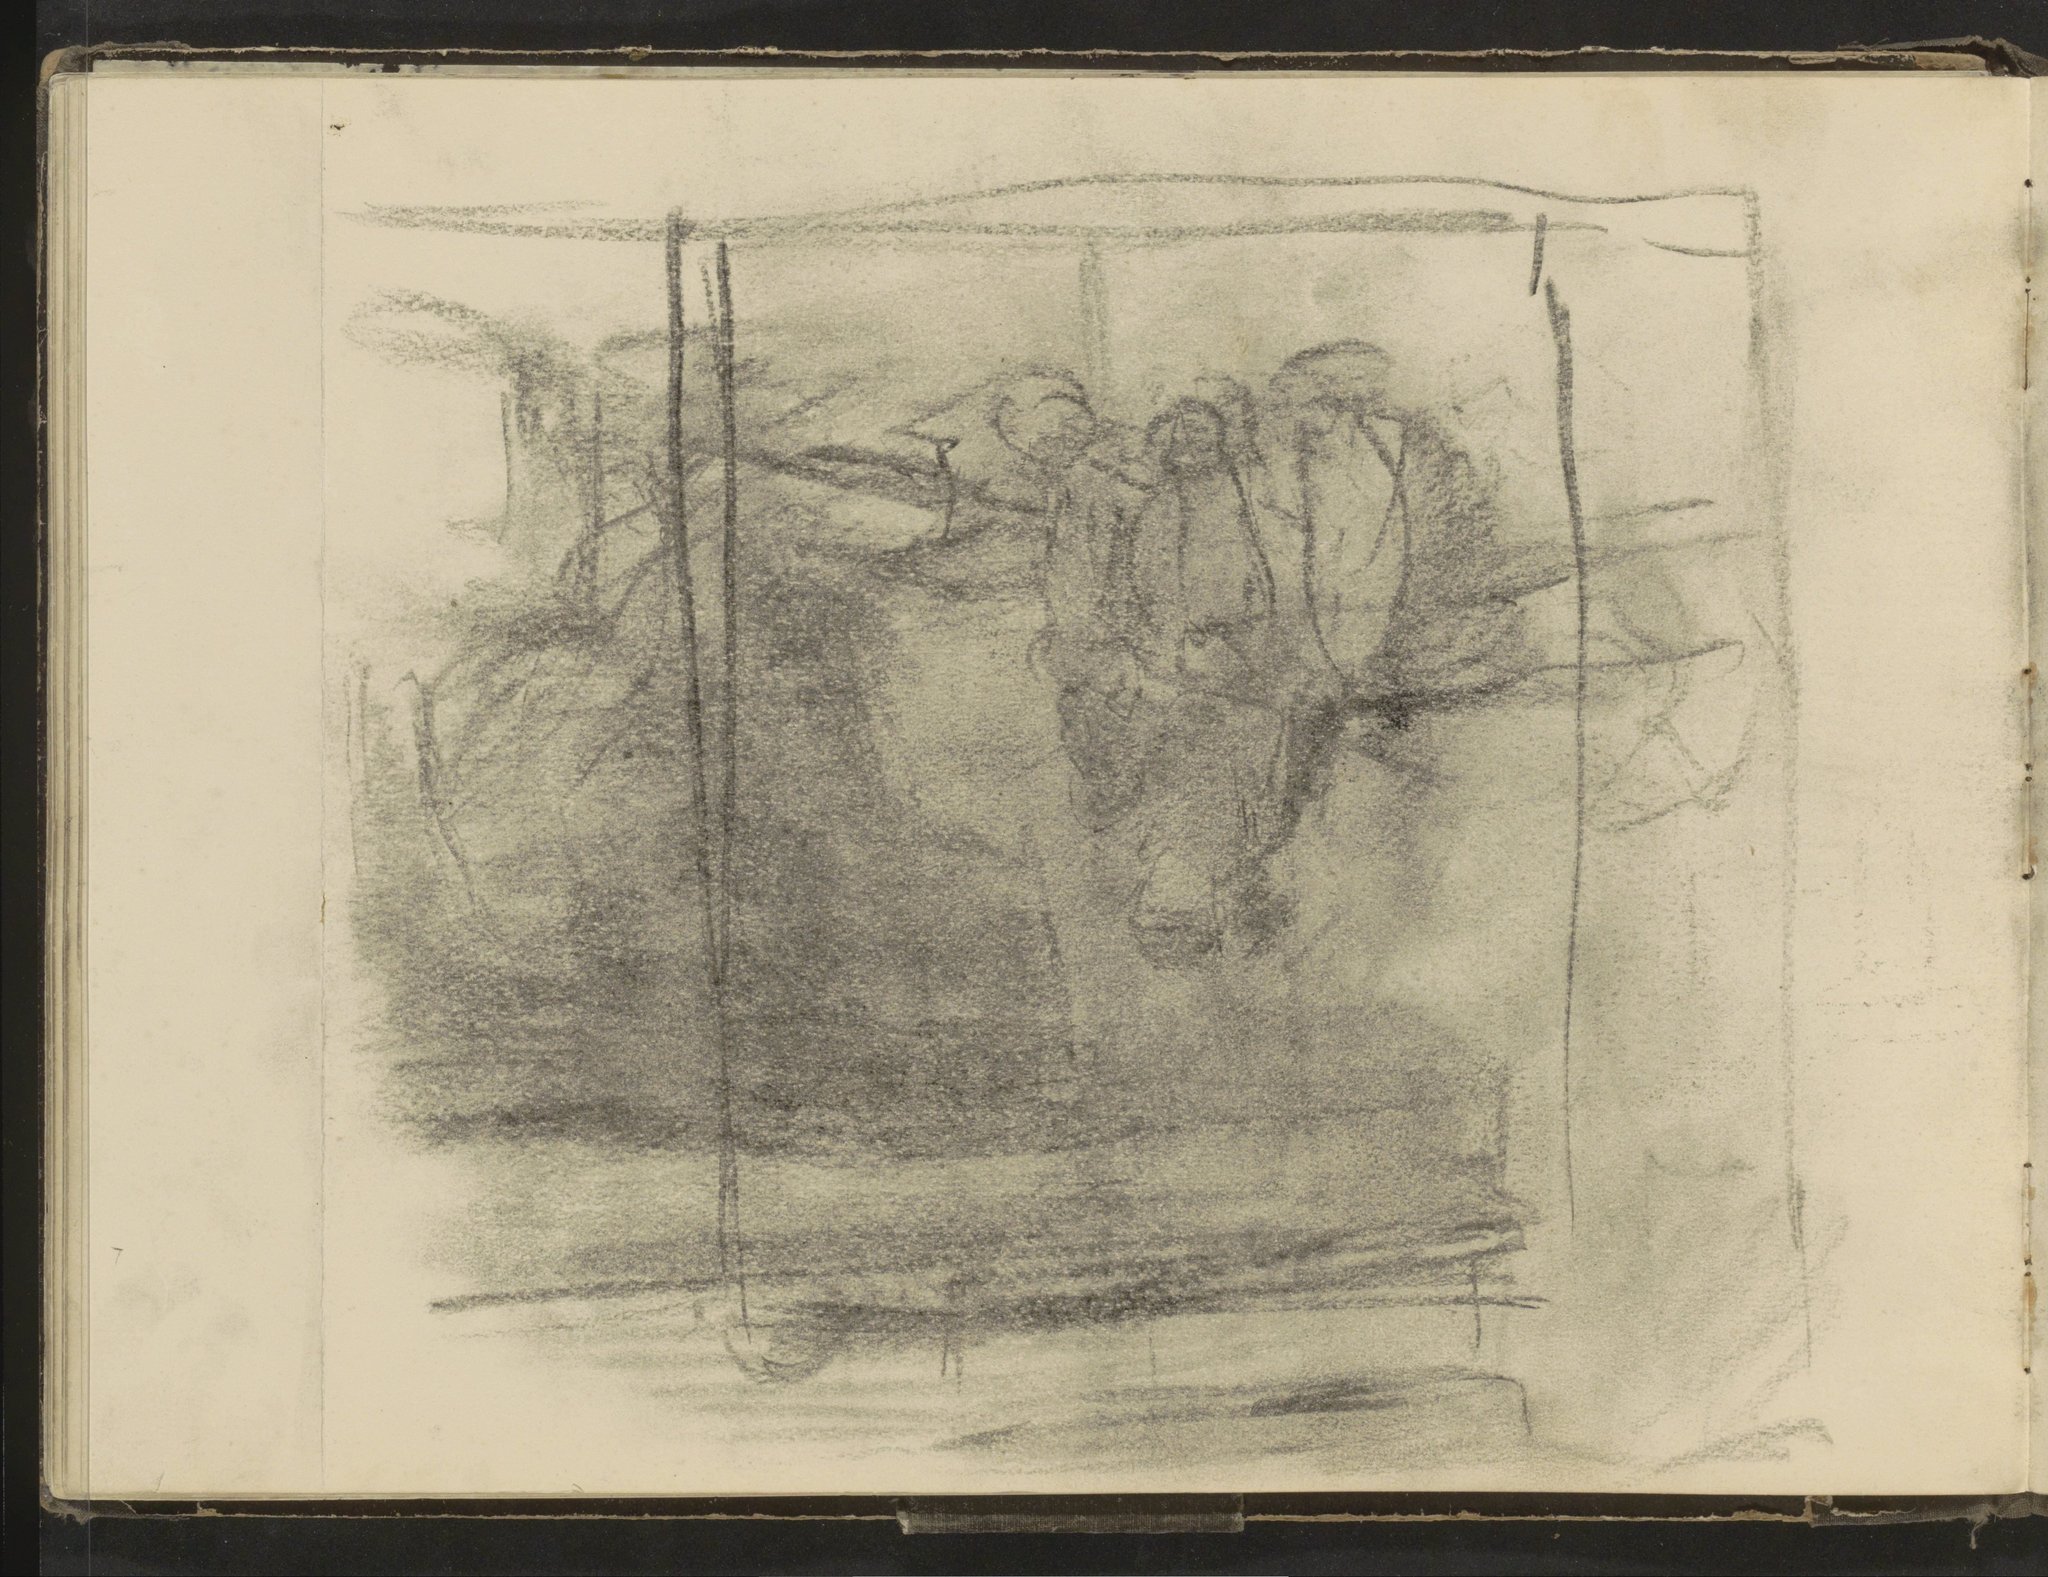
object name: sketchbook leaf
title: Zittende boer in een interieur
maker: albert neuhuys (1844-1914)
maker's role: draughtsman, painter, print maker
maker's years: 1844-1914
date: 1854-1914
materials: charcoal, paper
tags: sitting figure, farmers, interior of the house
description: Verso-zijde van een ongenummerde pagina tussen blad 20 en 21 uit een schetsboek met 43 bladen.